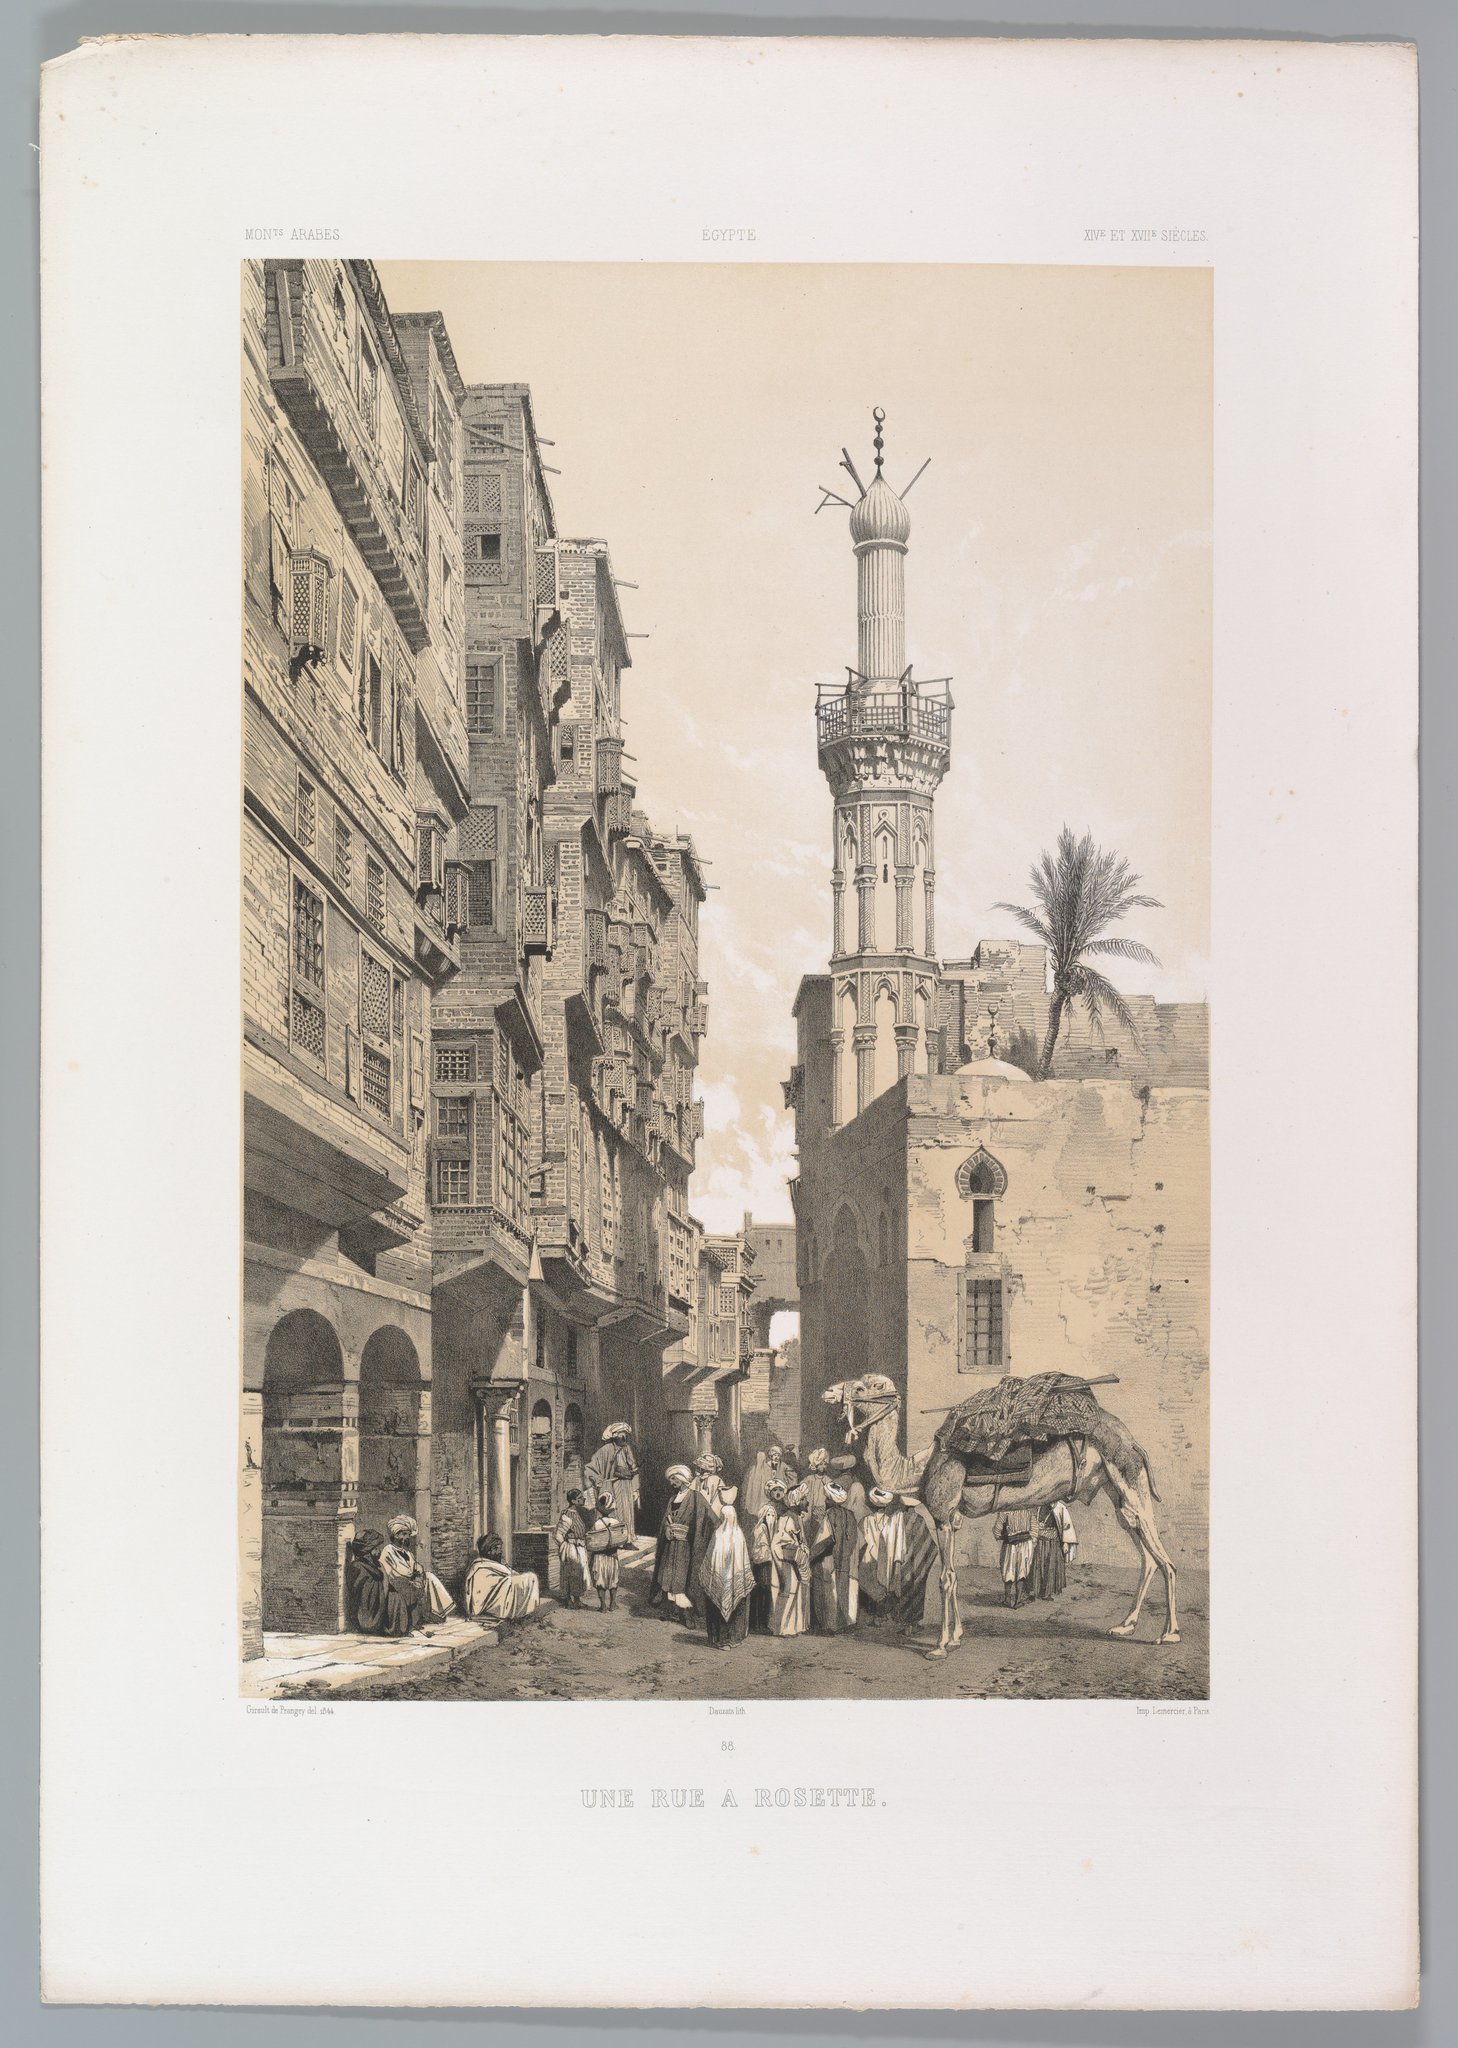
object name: lithograph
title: 88. Une rue, à Rosette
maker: joseph-philibert girault de prangey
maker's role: artist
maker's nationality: french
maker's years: 1804-1892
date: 1843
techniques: lithograph